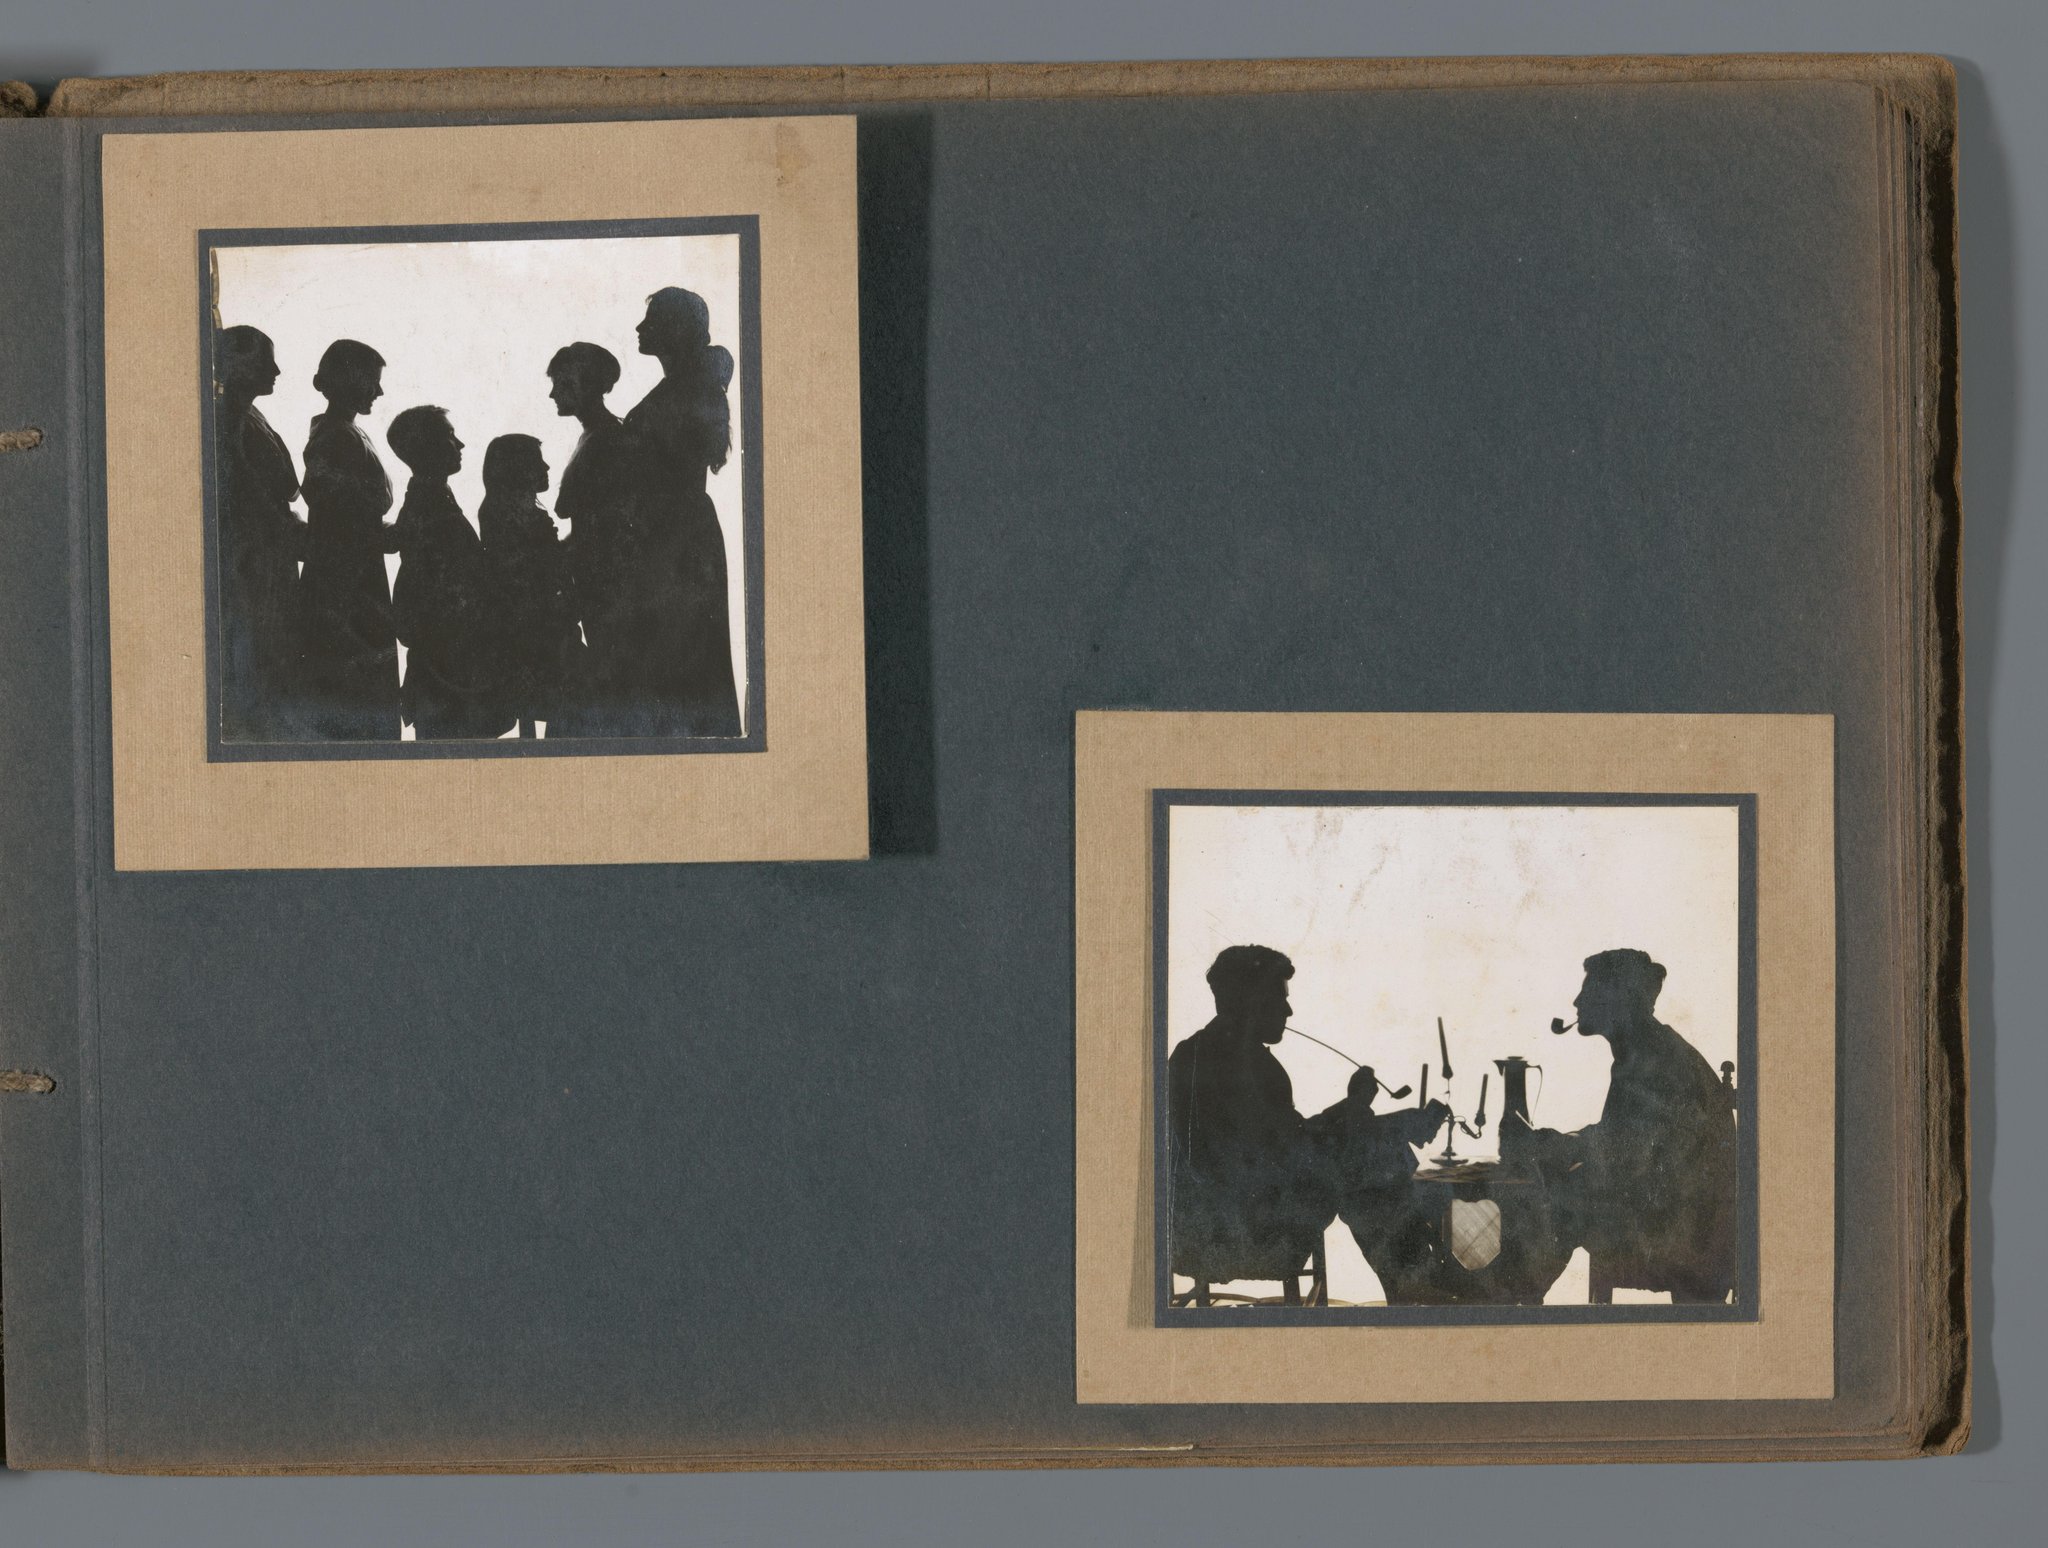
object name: photograph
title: Silhouetfoto's van twee mensen aan een tafel, en een groep mensen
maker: carolina frederika onnen (lien/loen)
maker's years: 1896-1983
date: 1914-1915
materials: paper, cardboard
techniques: gelatin silver print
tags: shadow-play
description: Deze foto's zijn onderdeel van een album.